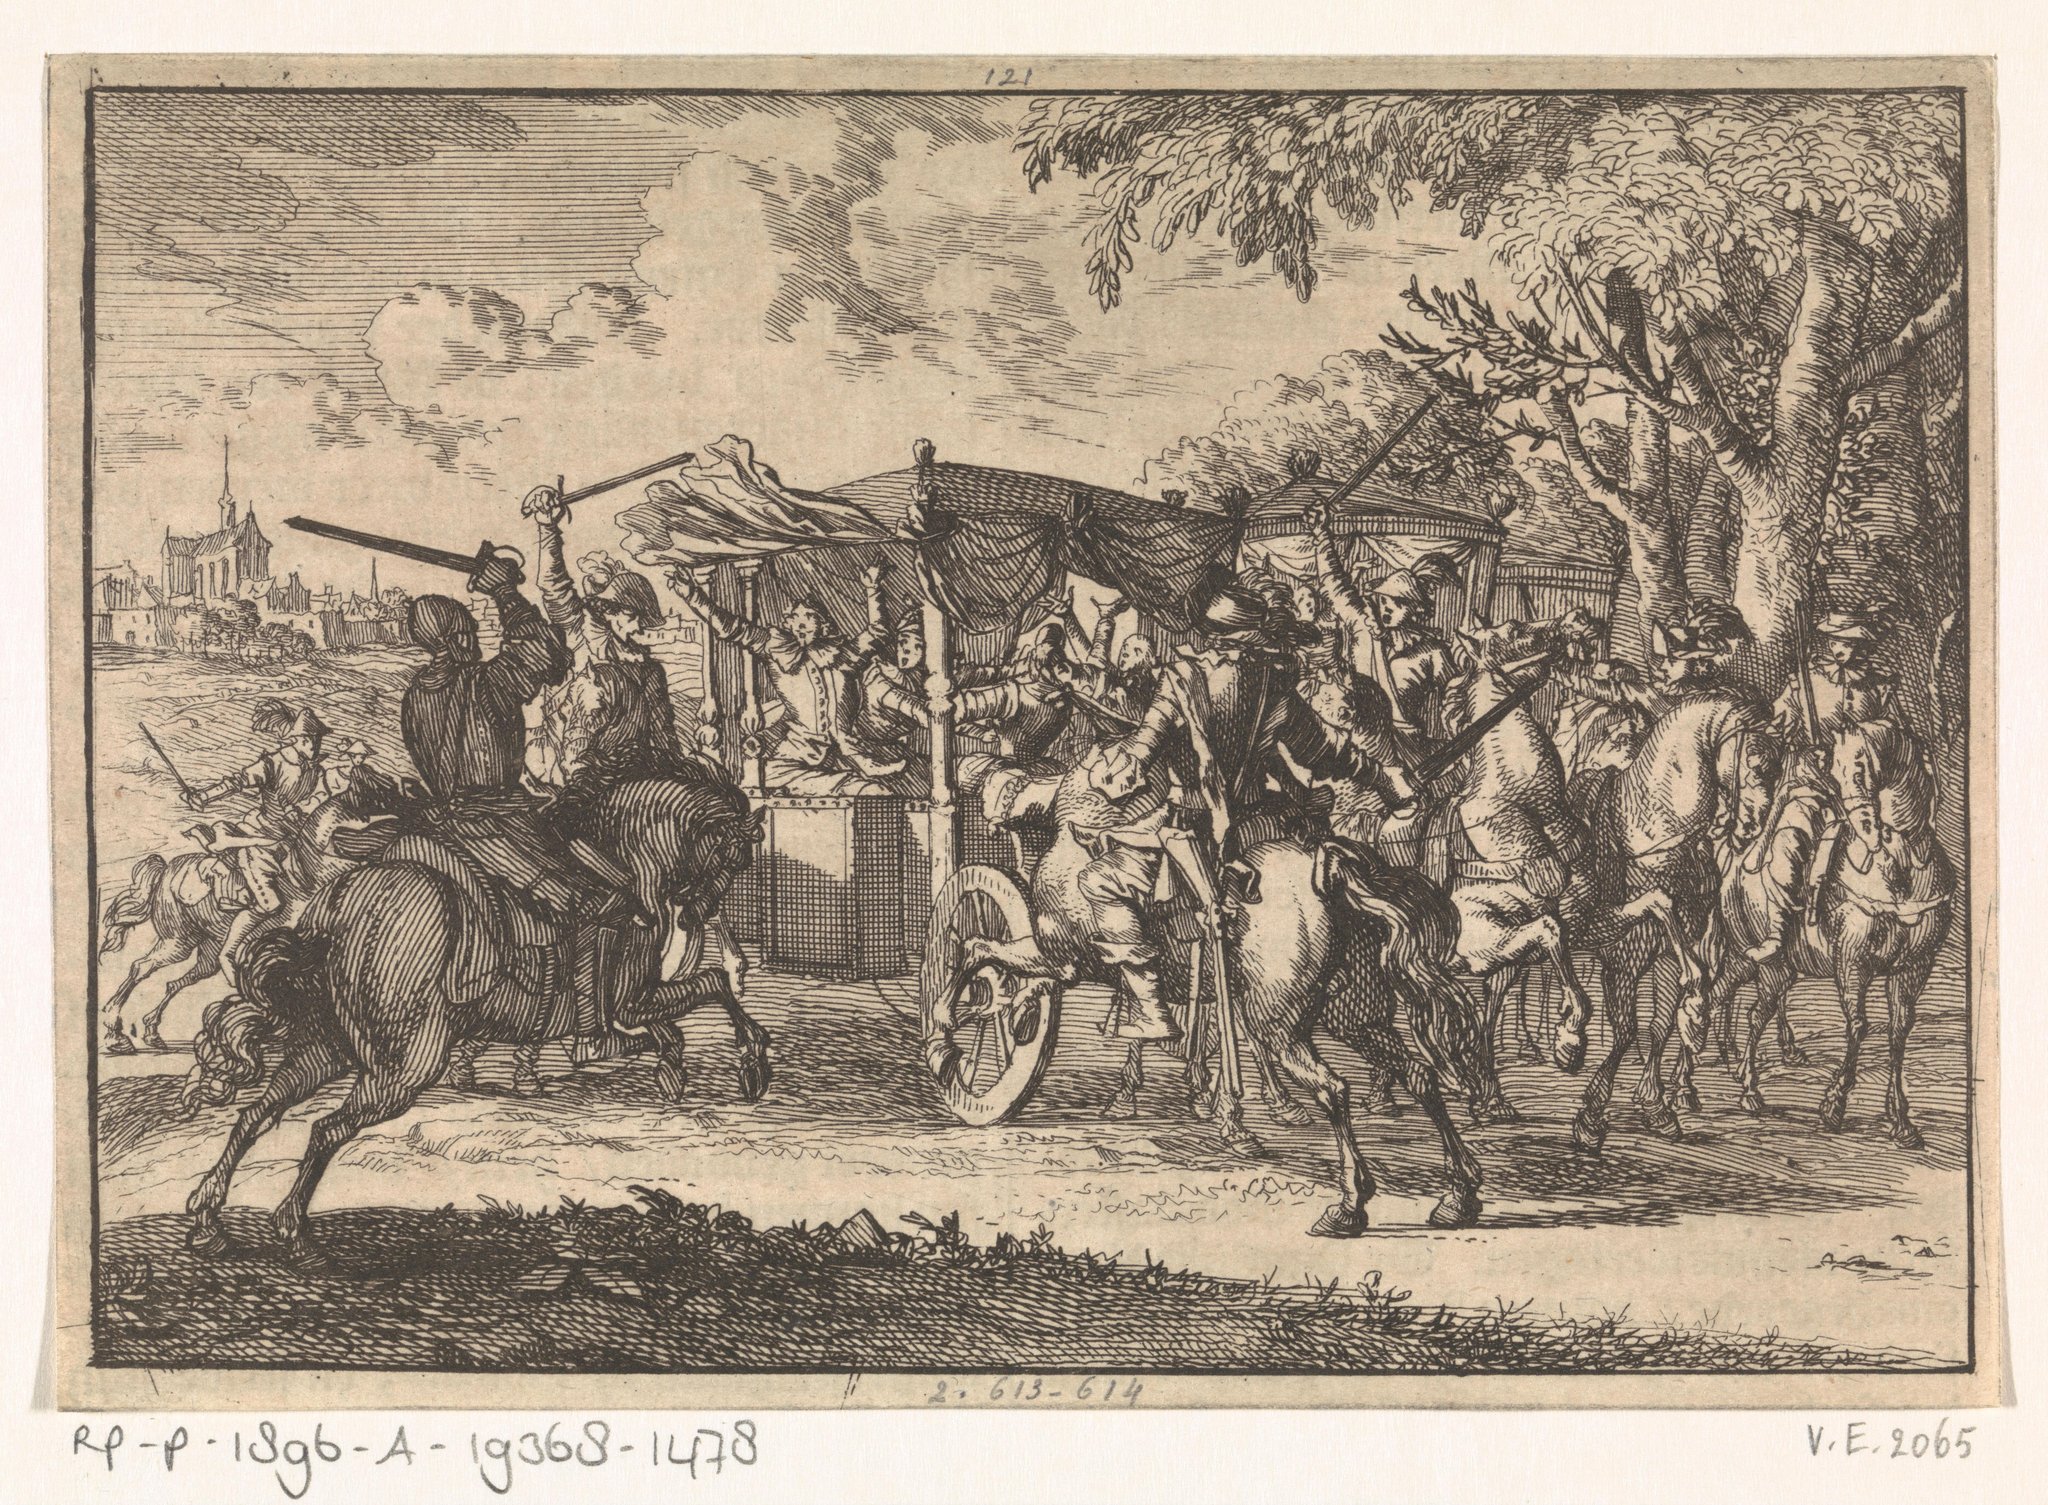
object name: print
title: Bij Vaals wordt de koets van de heer Van Wagtendonck, resident der Staten-Generaal, aangevallen door Spaanse ruiters, 1668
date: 1698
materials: paper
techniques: etching, letterpress printing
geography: leiden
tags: four-wheeled, animal-drawn vehicle, e.g.: cab, carriage, coach, (military) attack, robbery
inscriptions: collector's mark: Lugt 2228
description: Illustratie uit: Gottfried, Johann Ludwig. Historische kronyck; vervattende een (...) beschrijvingh der aldergedenckwaerdigste geschiedenissen des weerelds, van den aenvangh der scheppingh tot (...) 1576 (2 delen). Leiden: Pieter van der Aa, 1698, dl. II, p. 613.